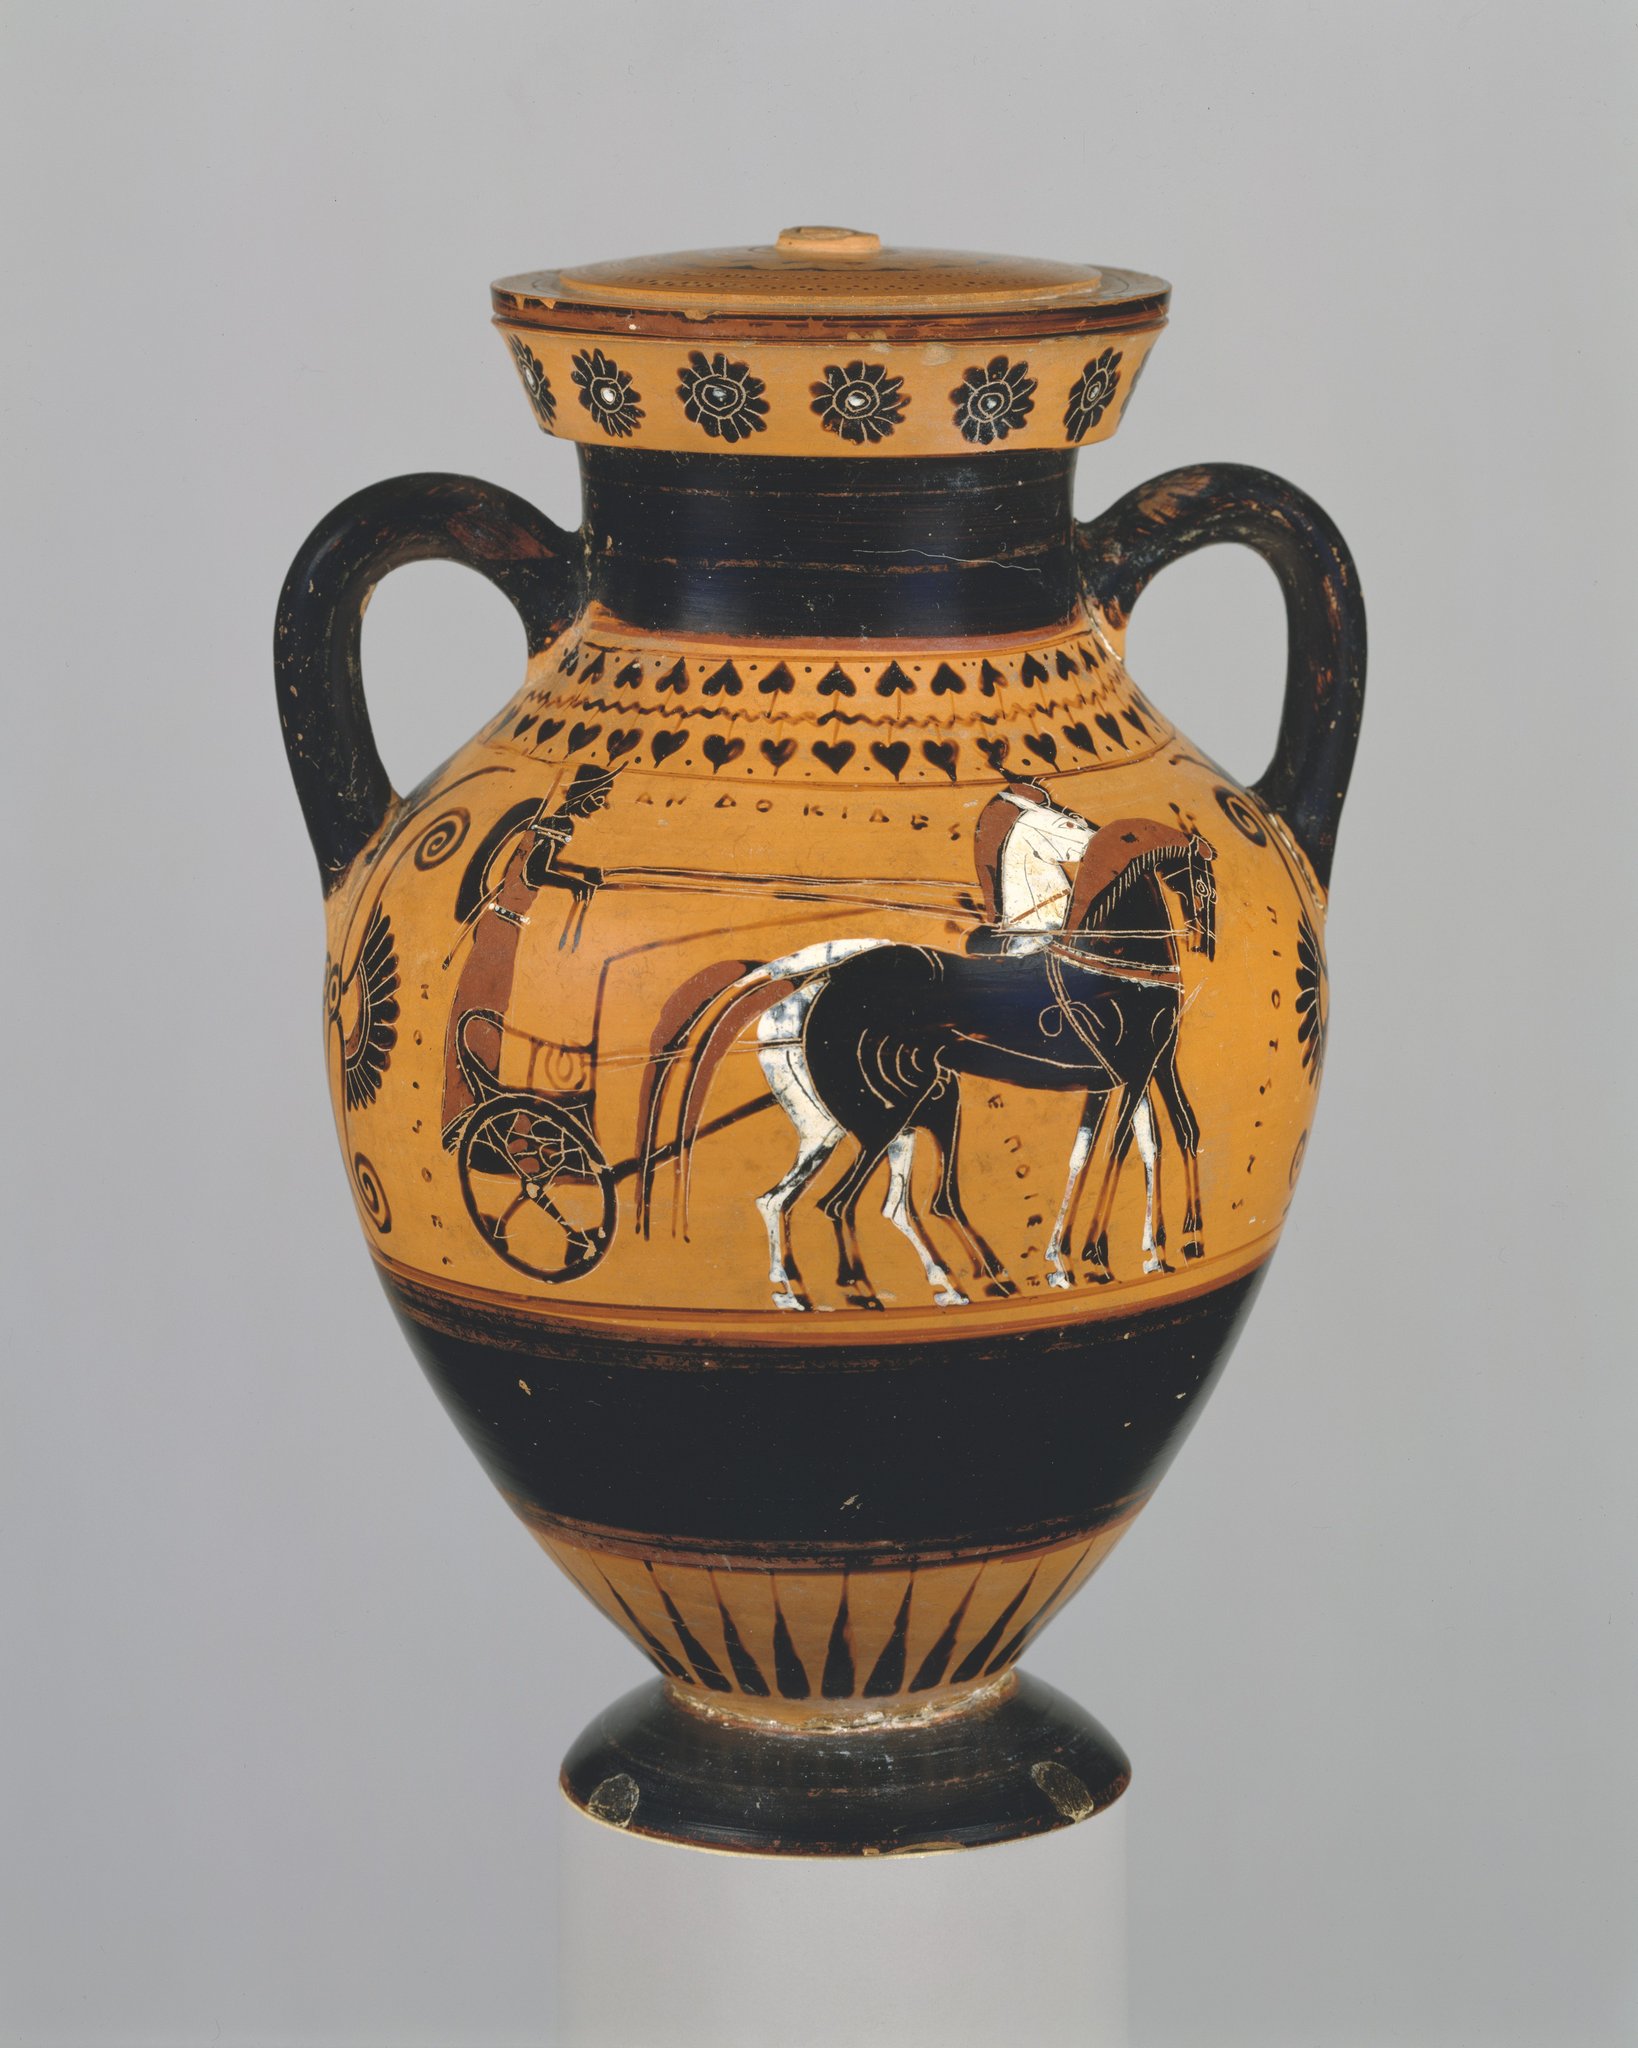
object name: amphora with lid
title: Terracotta amphora (jar)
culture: greek, attic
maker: andokides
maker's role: artist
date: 540 BCE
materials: terracotta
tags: men,horses,chariots